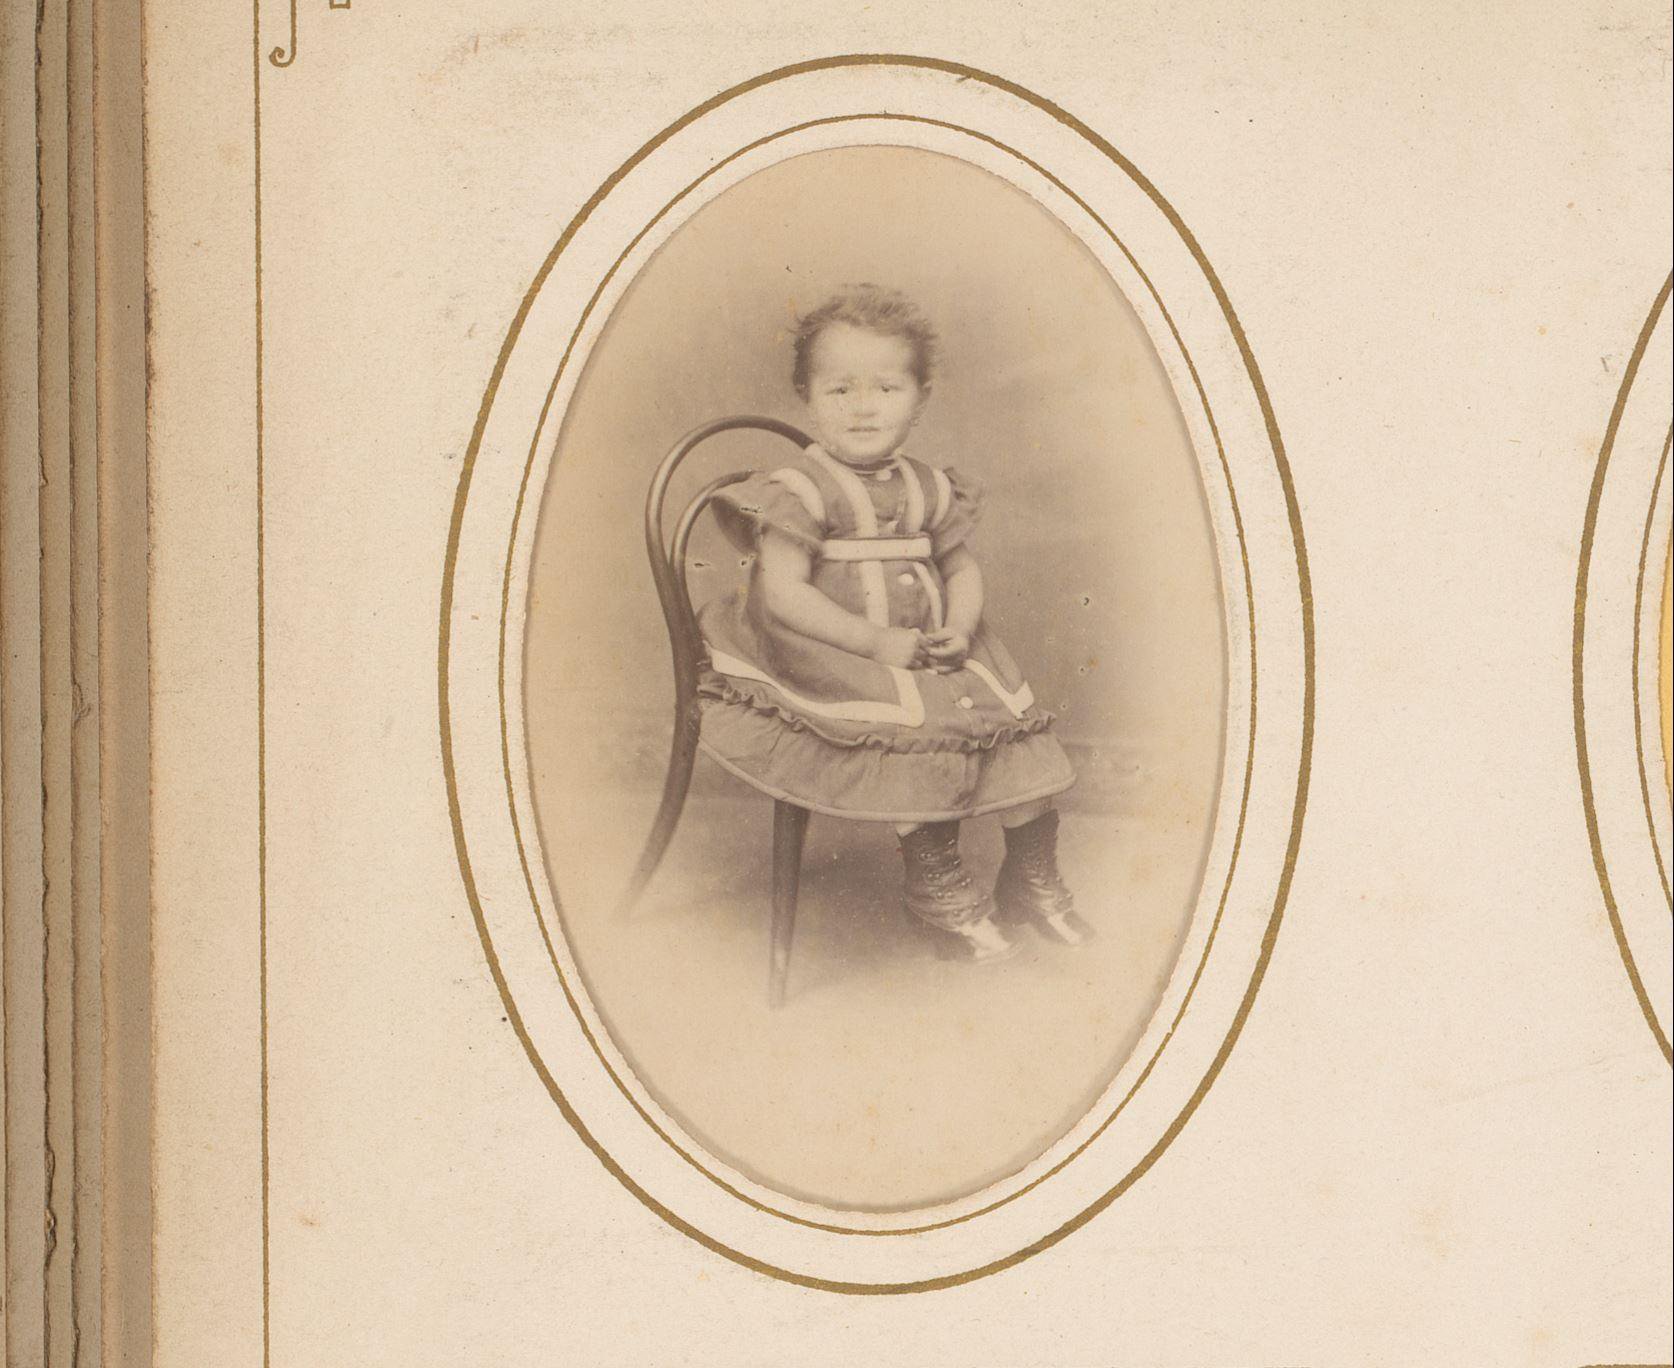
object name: photograph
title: Portret van een zittend meisje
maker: charles emmanuel dhoy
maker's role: fotograaf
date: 1864-1890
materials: cardboard, photographic support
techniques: albumen print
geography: brussels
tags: historical persons - bb - woman, toddler (female), chair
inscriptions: inscription: ‘Charles D'hoy/ PHOTOGRAPHE/ Rue courte du jour 25 près du Pont Madou/ WALPOORT BRUG/ GAND’